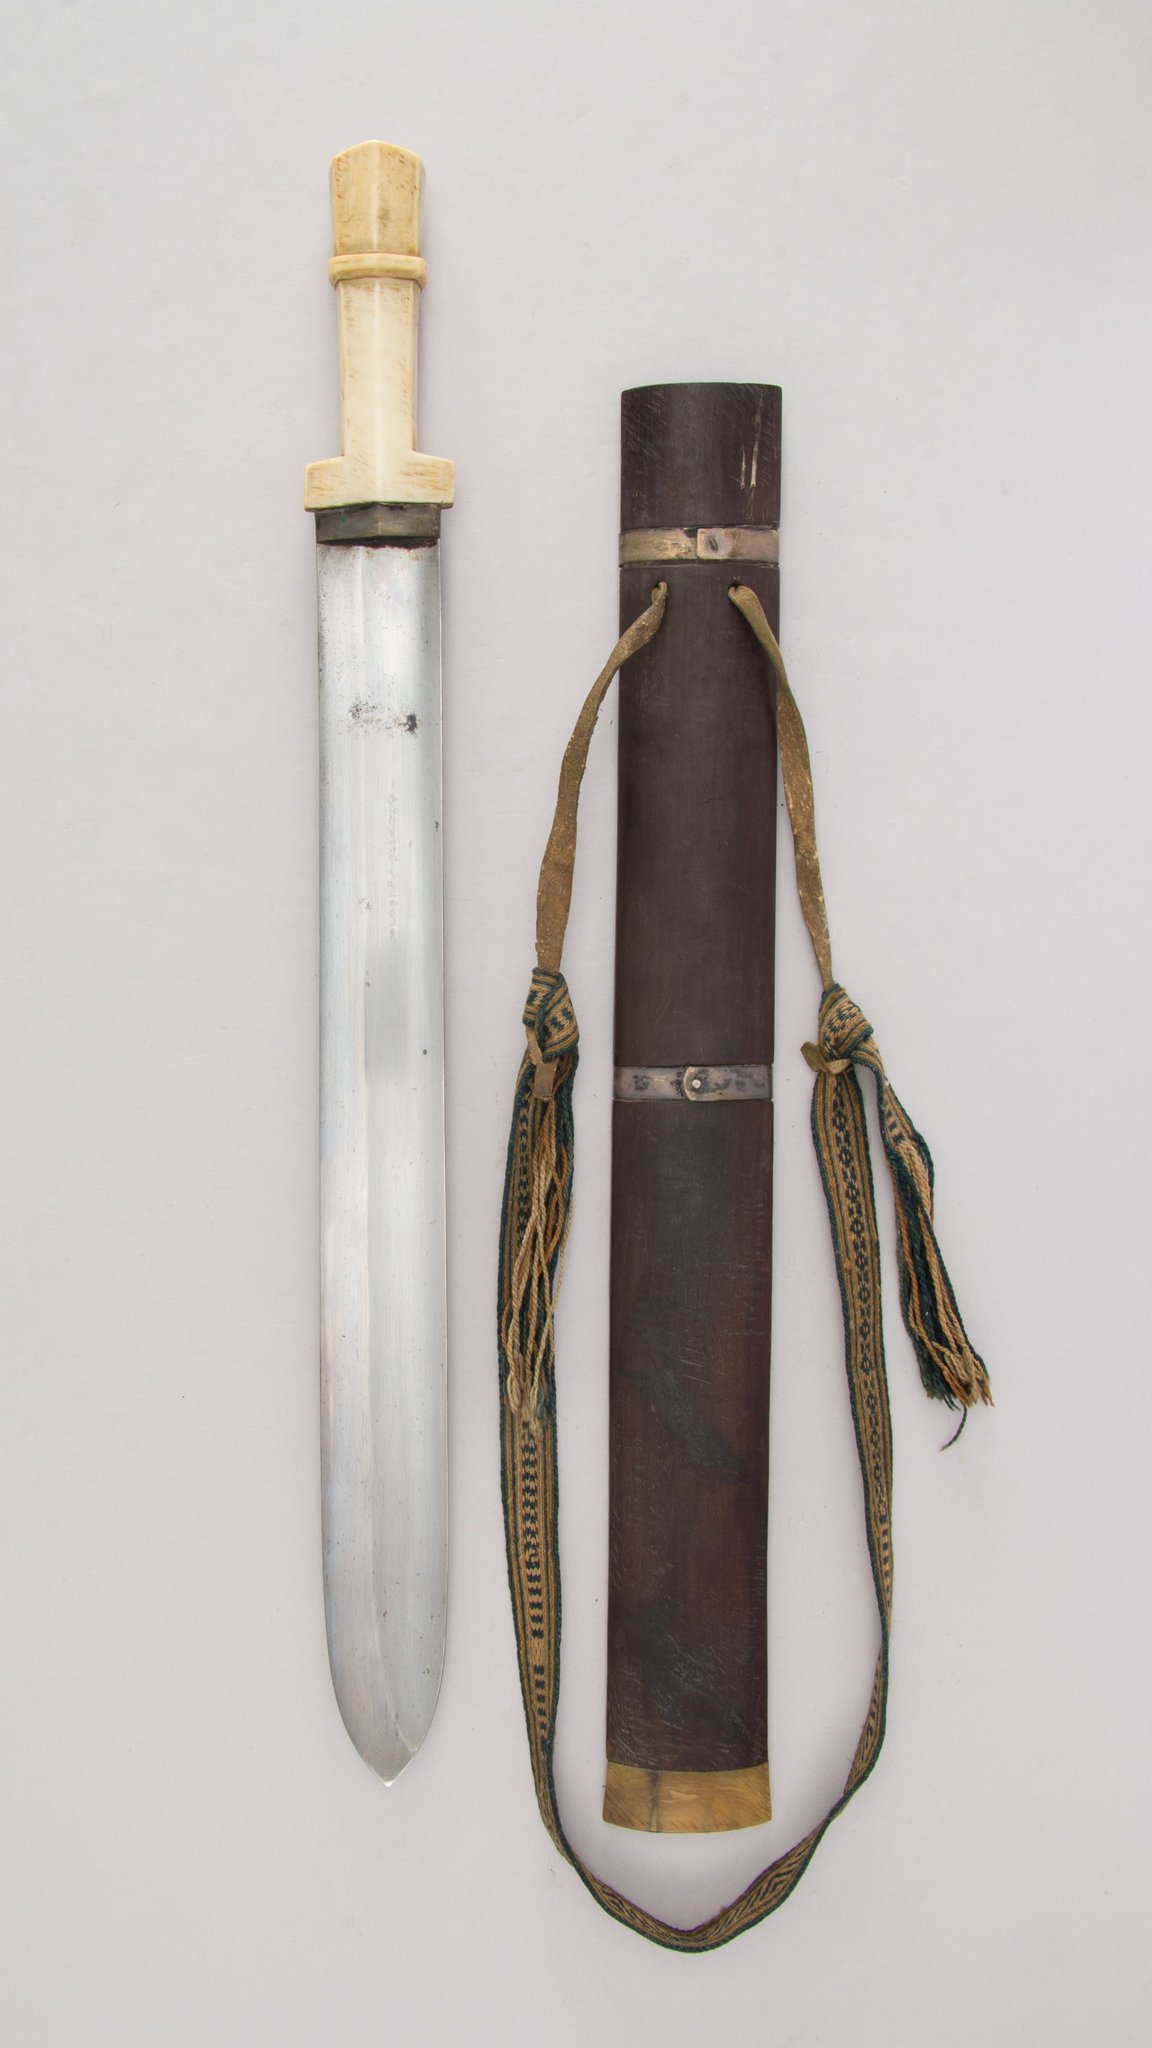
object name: sword with scabbard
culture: bhutanese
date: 1801-1900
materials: horn, ivory, silver, textile, wood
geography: bhutan